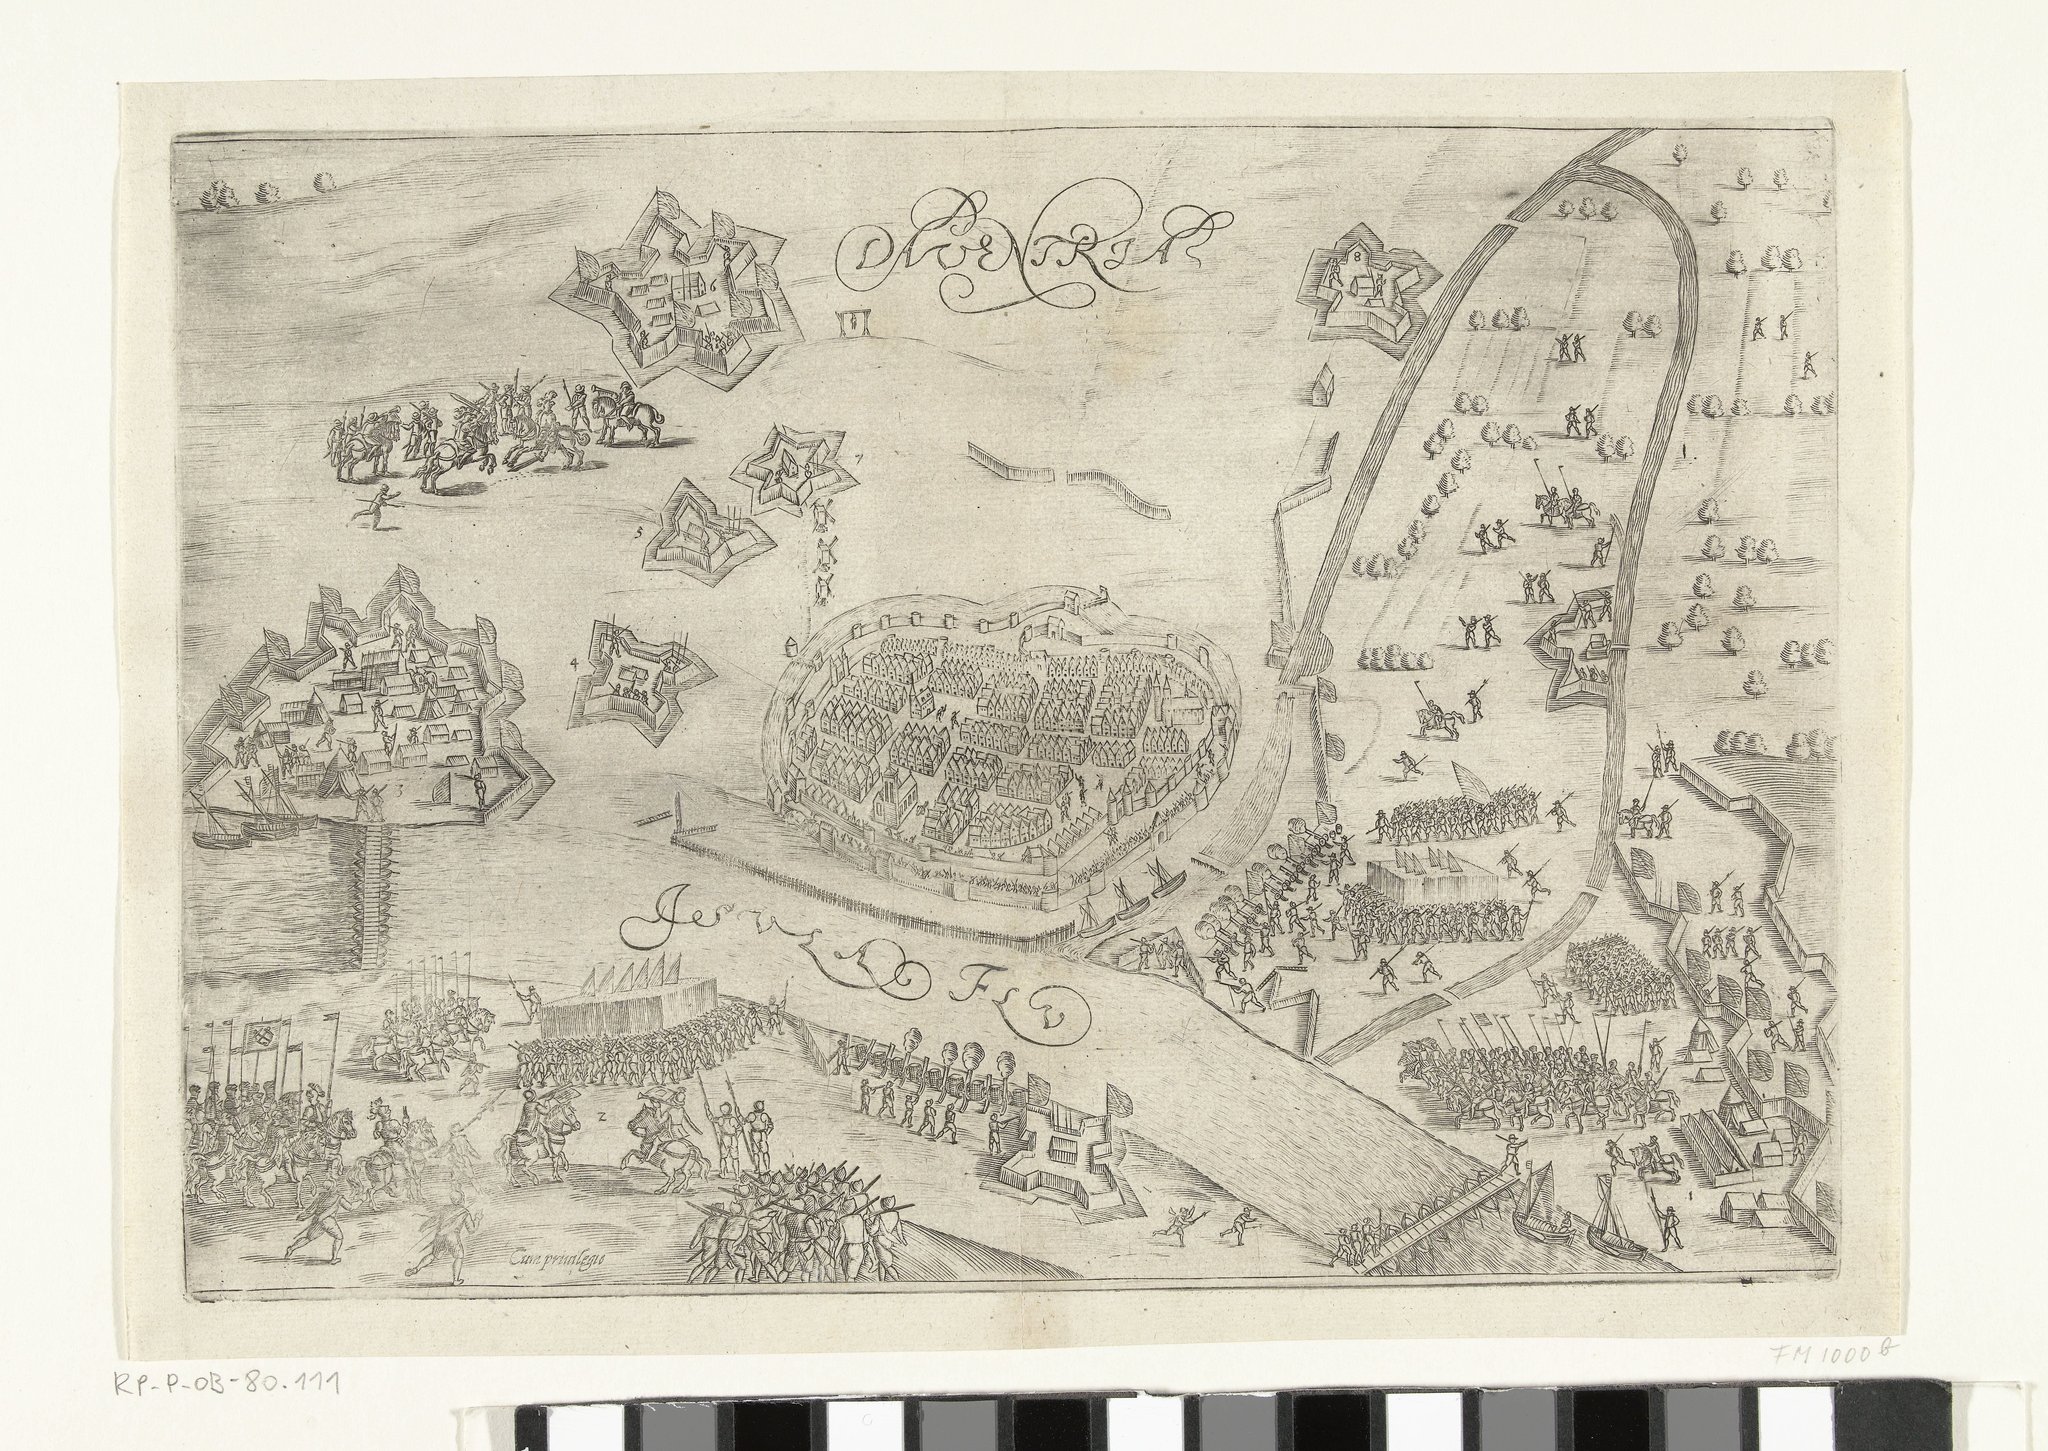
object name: history print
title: Beleg en inname van Deventer, 1591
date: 1600-1601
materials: paper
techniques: engraving, letterpress printing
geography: northern netherlands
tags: improvised bridge, temporary bridge ~ military engineering, capture of city (after the siege), deventer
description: Gebruikt als illustratie in: J.J. Orlers, De oorlochs-daden vanden doorlichtigen vorst Mavrits van Nassav. Of den nievven vermeerden Nassavschen lauren-crans: Warachtige beschrijvinghe van alle de belegeringhen ende victorien, te water ende te lande. Die God almachich[!], tot welvaren der Vereenichde Nederlanden te wege gebracht ende gegeven heeft, J.J. Orlers en H. van Haestens, Leiden 1619, p. 124.